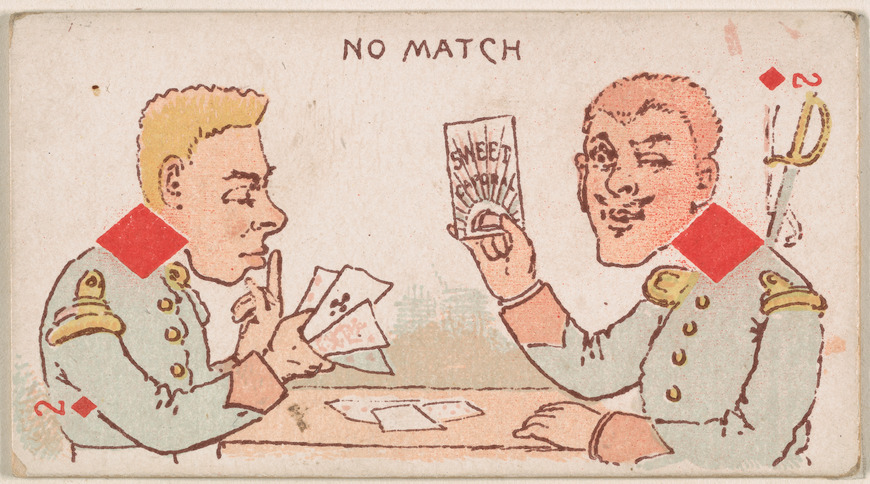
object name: print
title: Two of Diamonds, No Match, from Harlequin Cards, 2nd Series (N220) issued by Kinney Bros.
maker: kinney brothers tobacco company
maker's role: publisher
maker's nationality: american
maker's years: 1869-2011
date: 1889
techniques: color lithograph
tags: playing cards